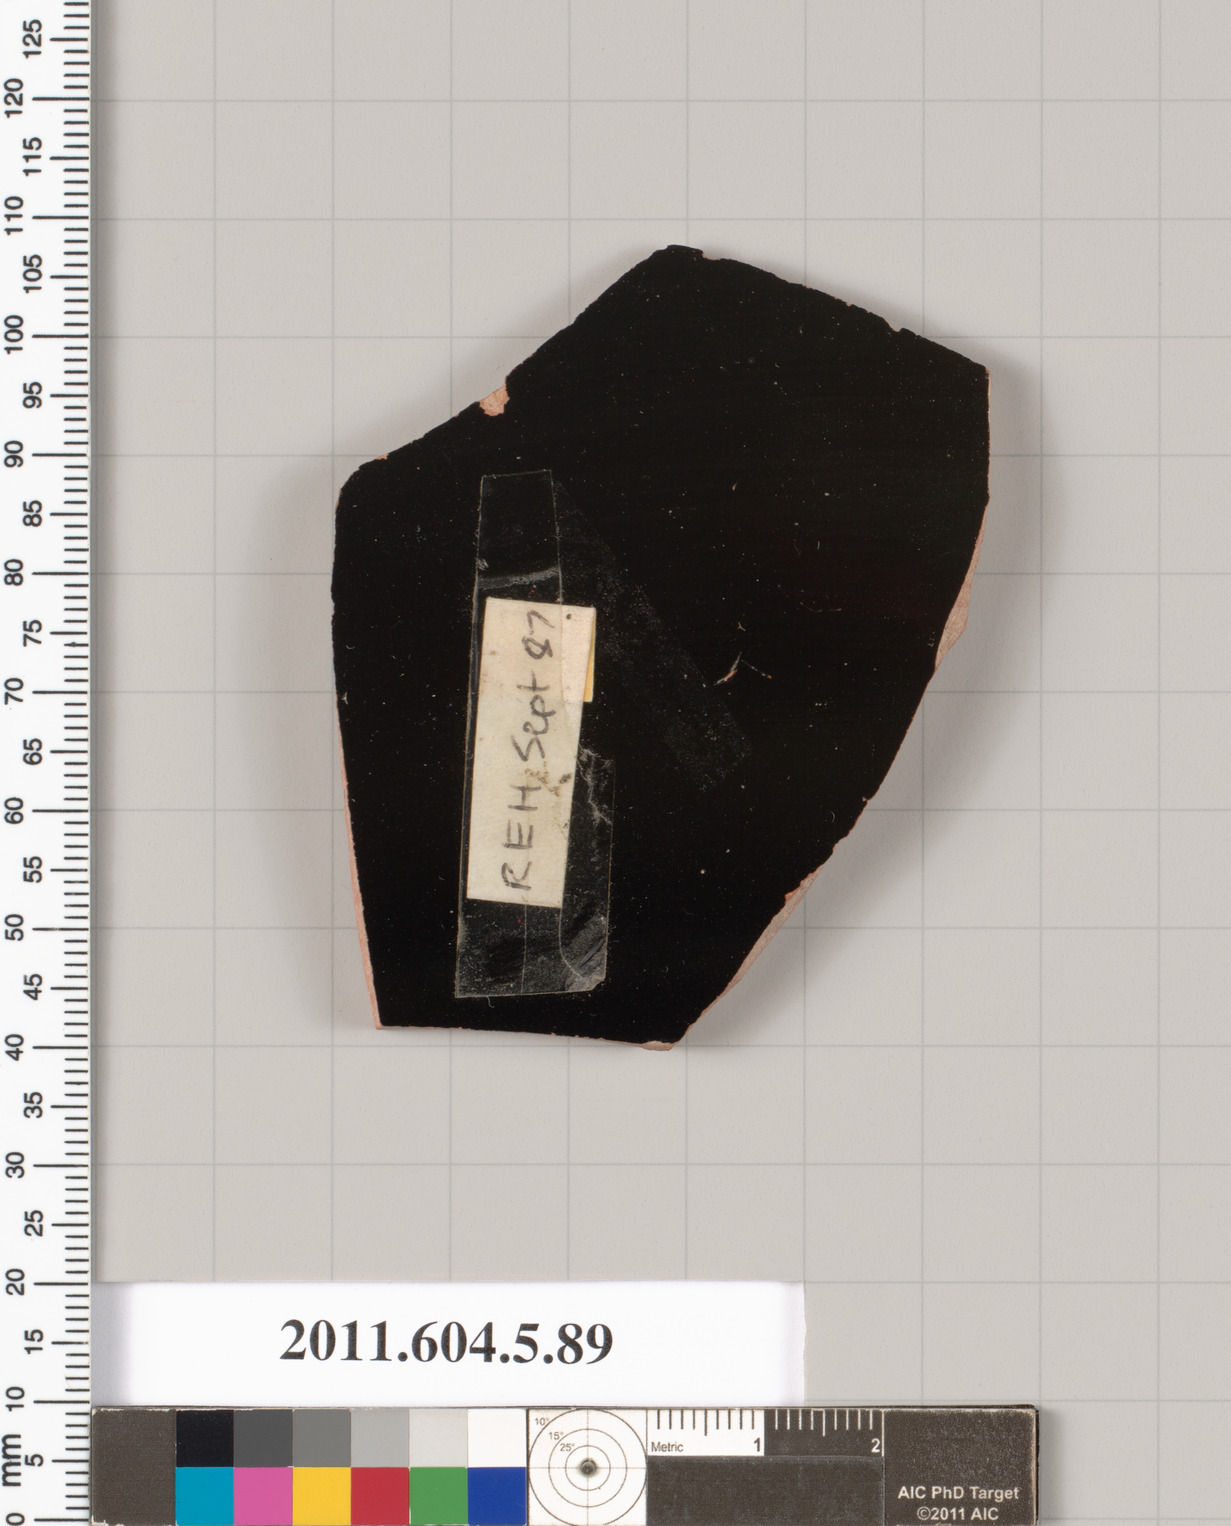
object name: kylix fragment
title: Terracotta fragment of a kylix (drinking cup)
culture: greek, attic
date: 510-500 BCE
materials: terracotta